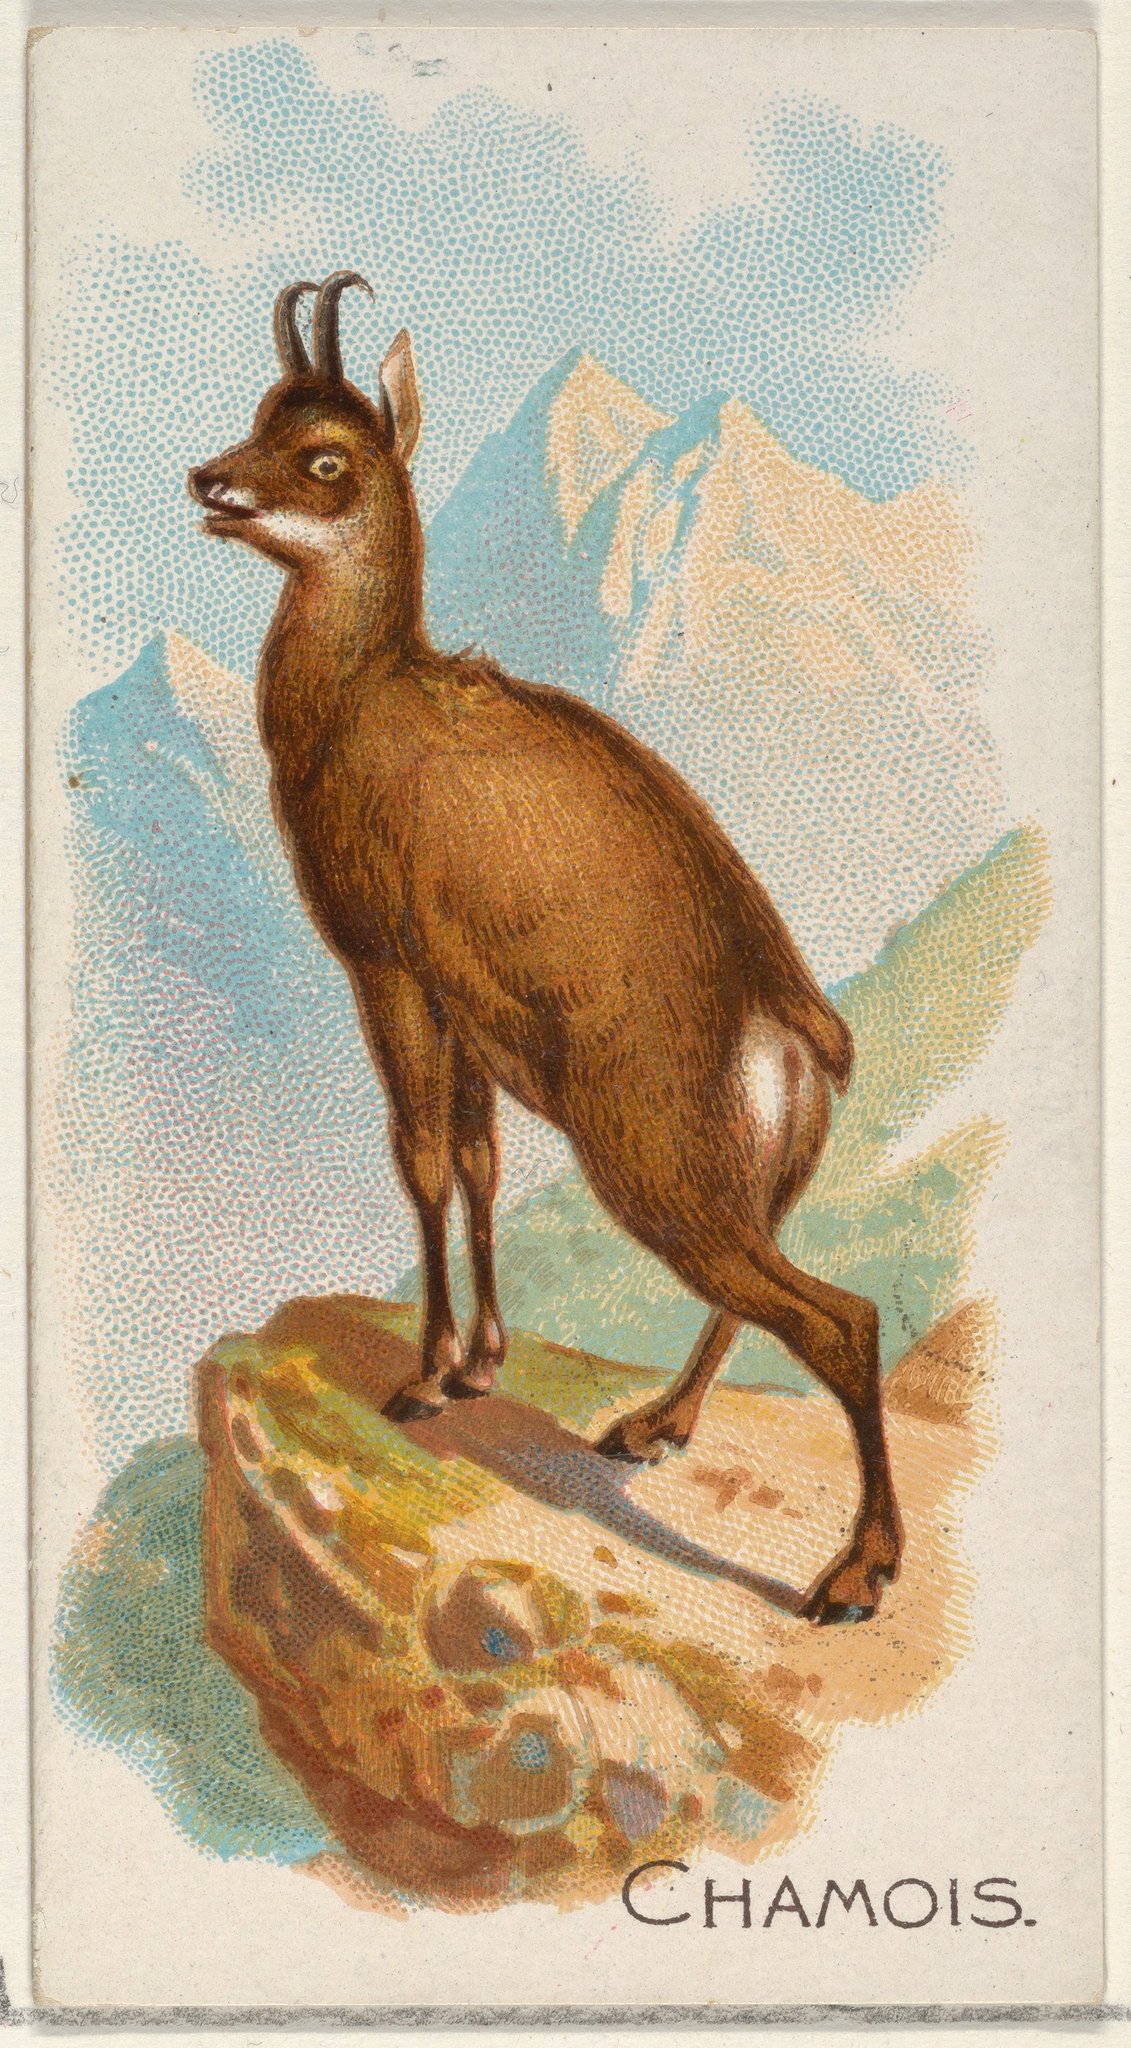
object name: print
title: Chamois, from the Quadrupeds series (N21) for Allen & Ginter Cigarettes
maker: allen & ginter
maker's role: publisher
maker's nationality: american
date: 1890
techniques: color lithograph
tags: animals